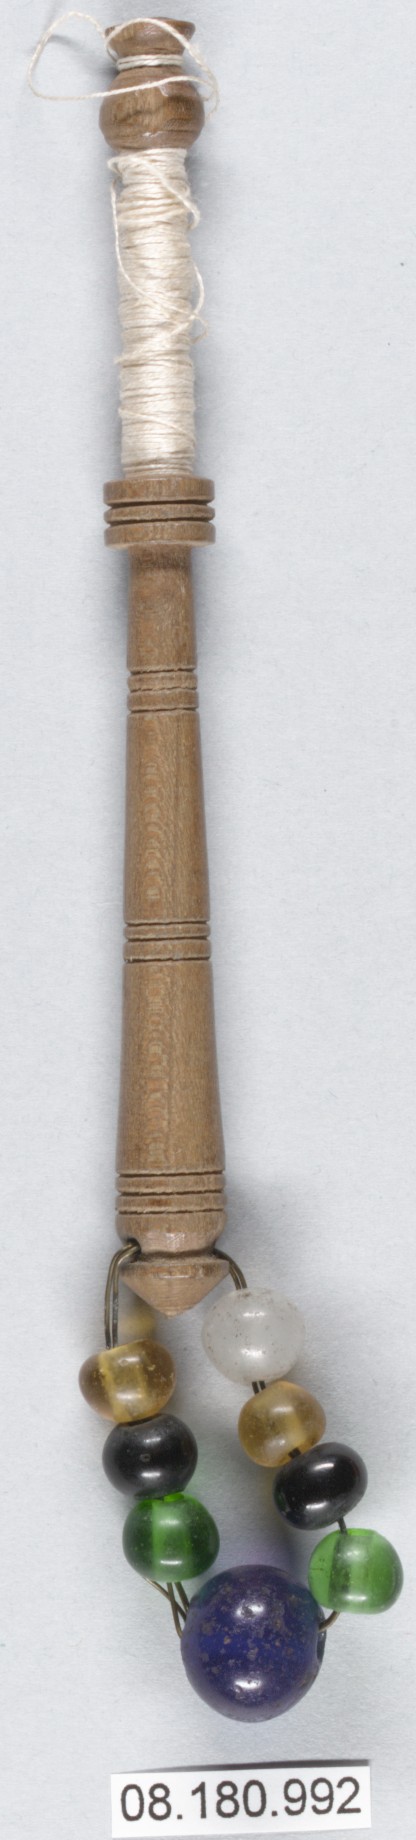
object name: bobbin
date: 1801-1900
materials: wood